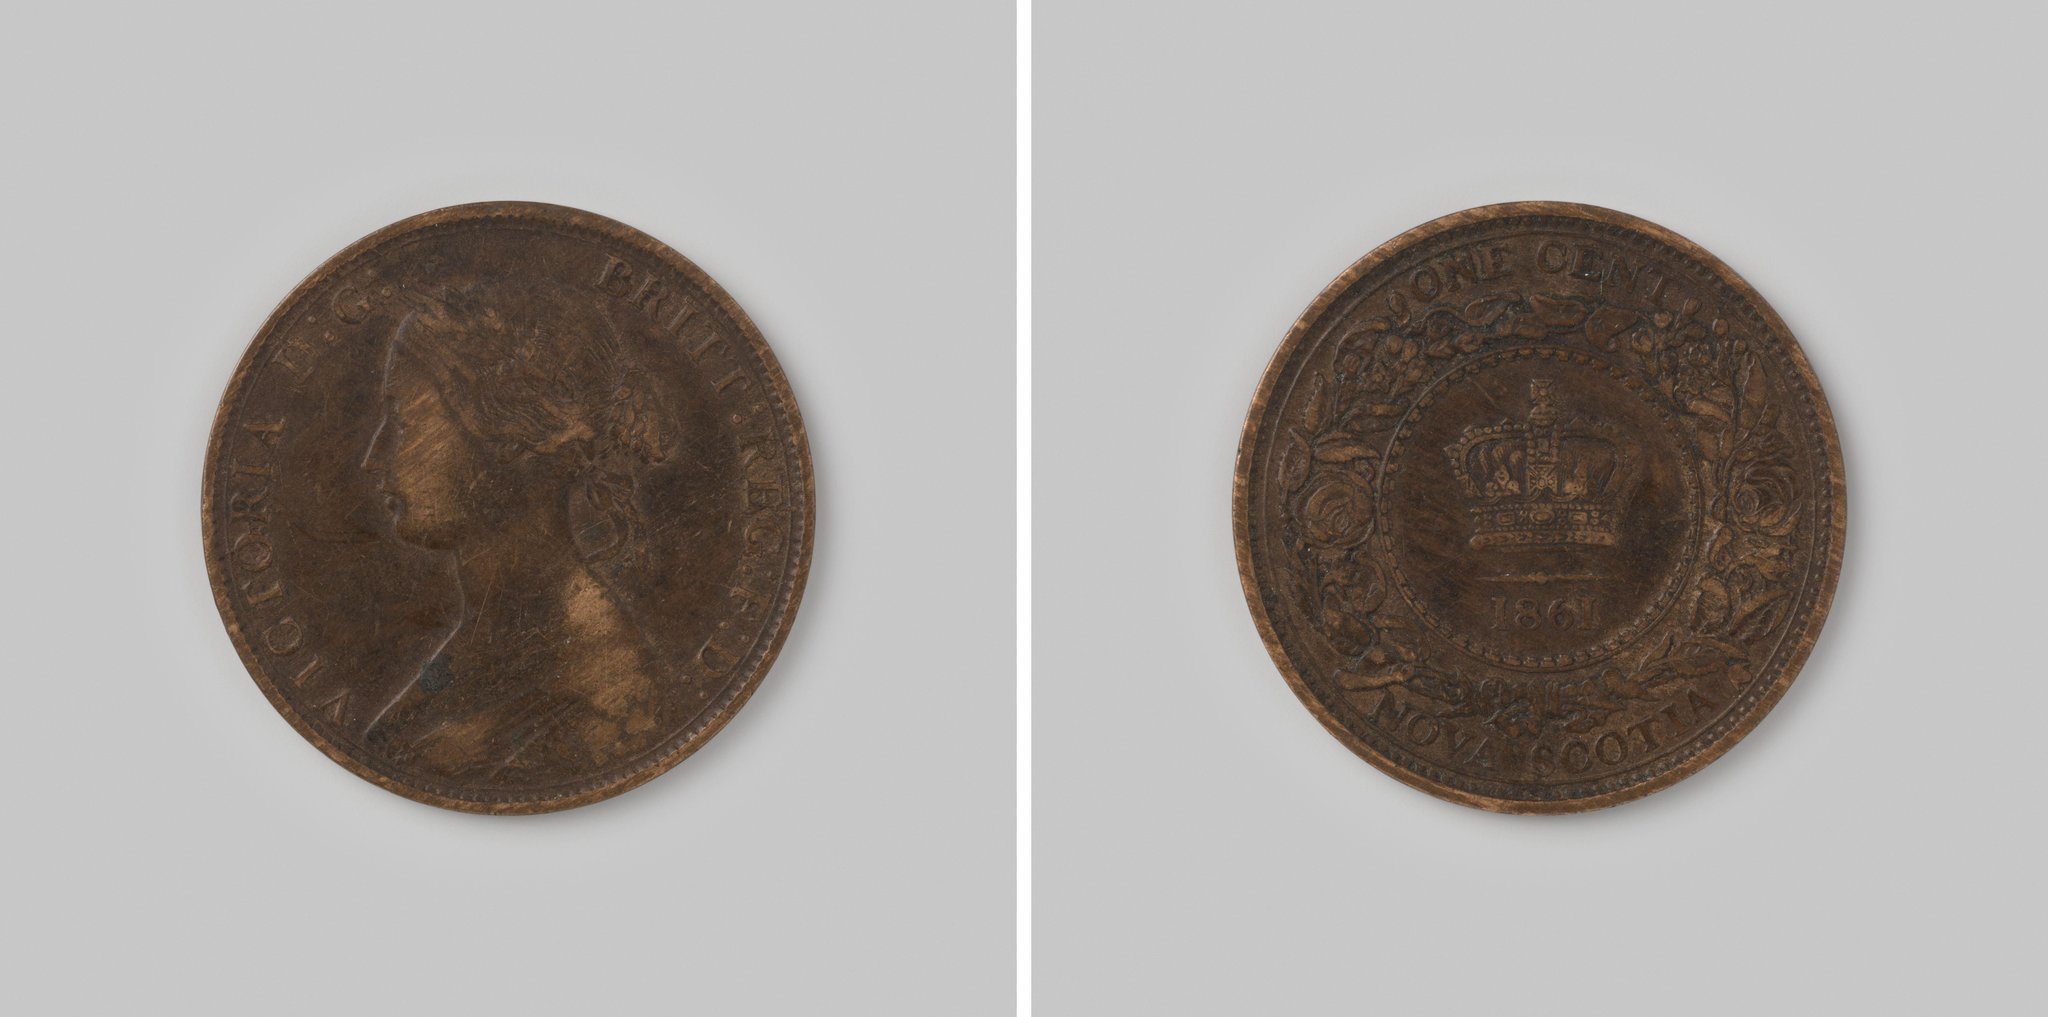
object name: coin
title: Nova Scotia, Canada, cent, 1861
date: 1861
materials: bronze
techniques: striking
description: Bronzen munt. Voorzijde: borstbeeld met lauwerkrans van vorstin Victoria naar links. Keerzijde: binnen twee sameengebonden takken kroon, waaronder jaartal. Als omschrift bovenaan waarde-aanduiding en onderaan lands-aanduiding. Gladde rand.